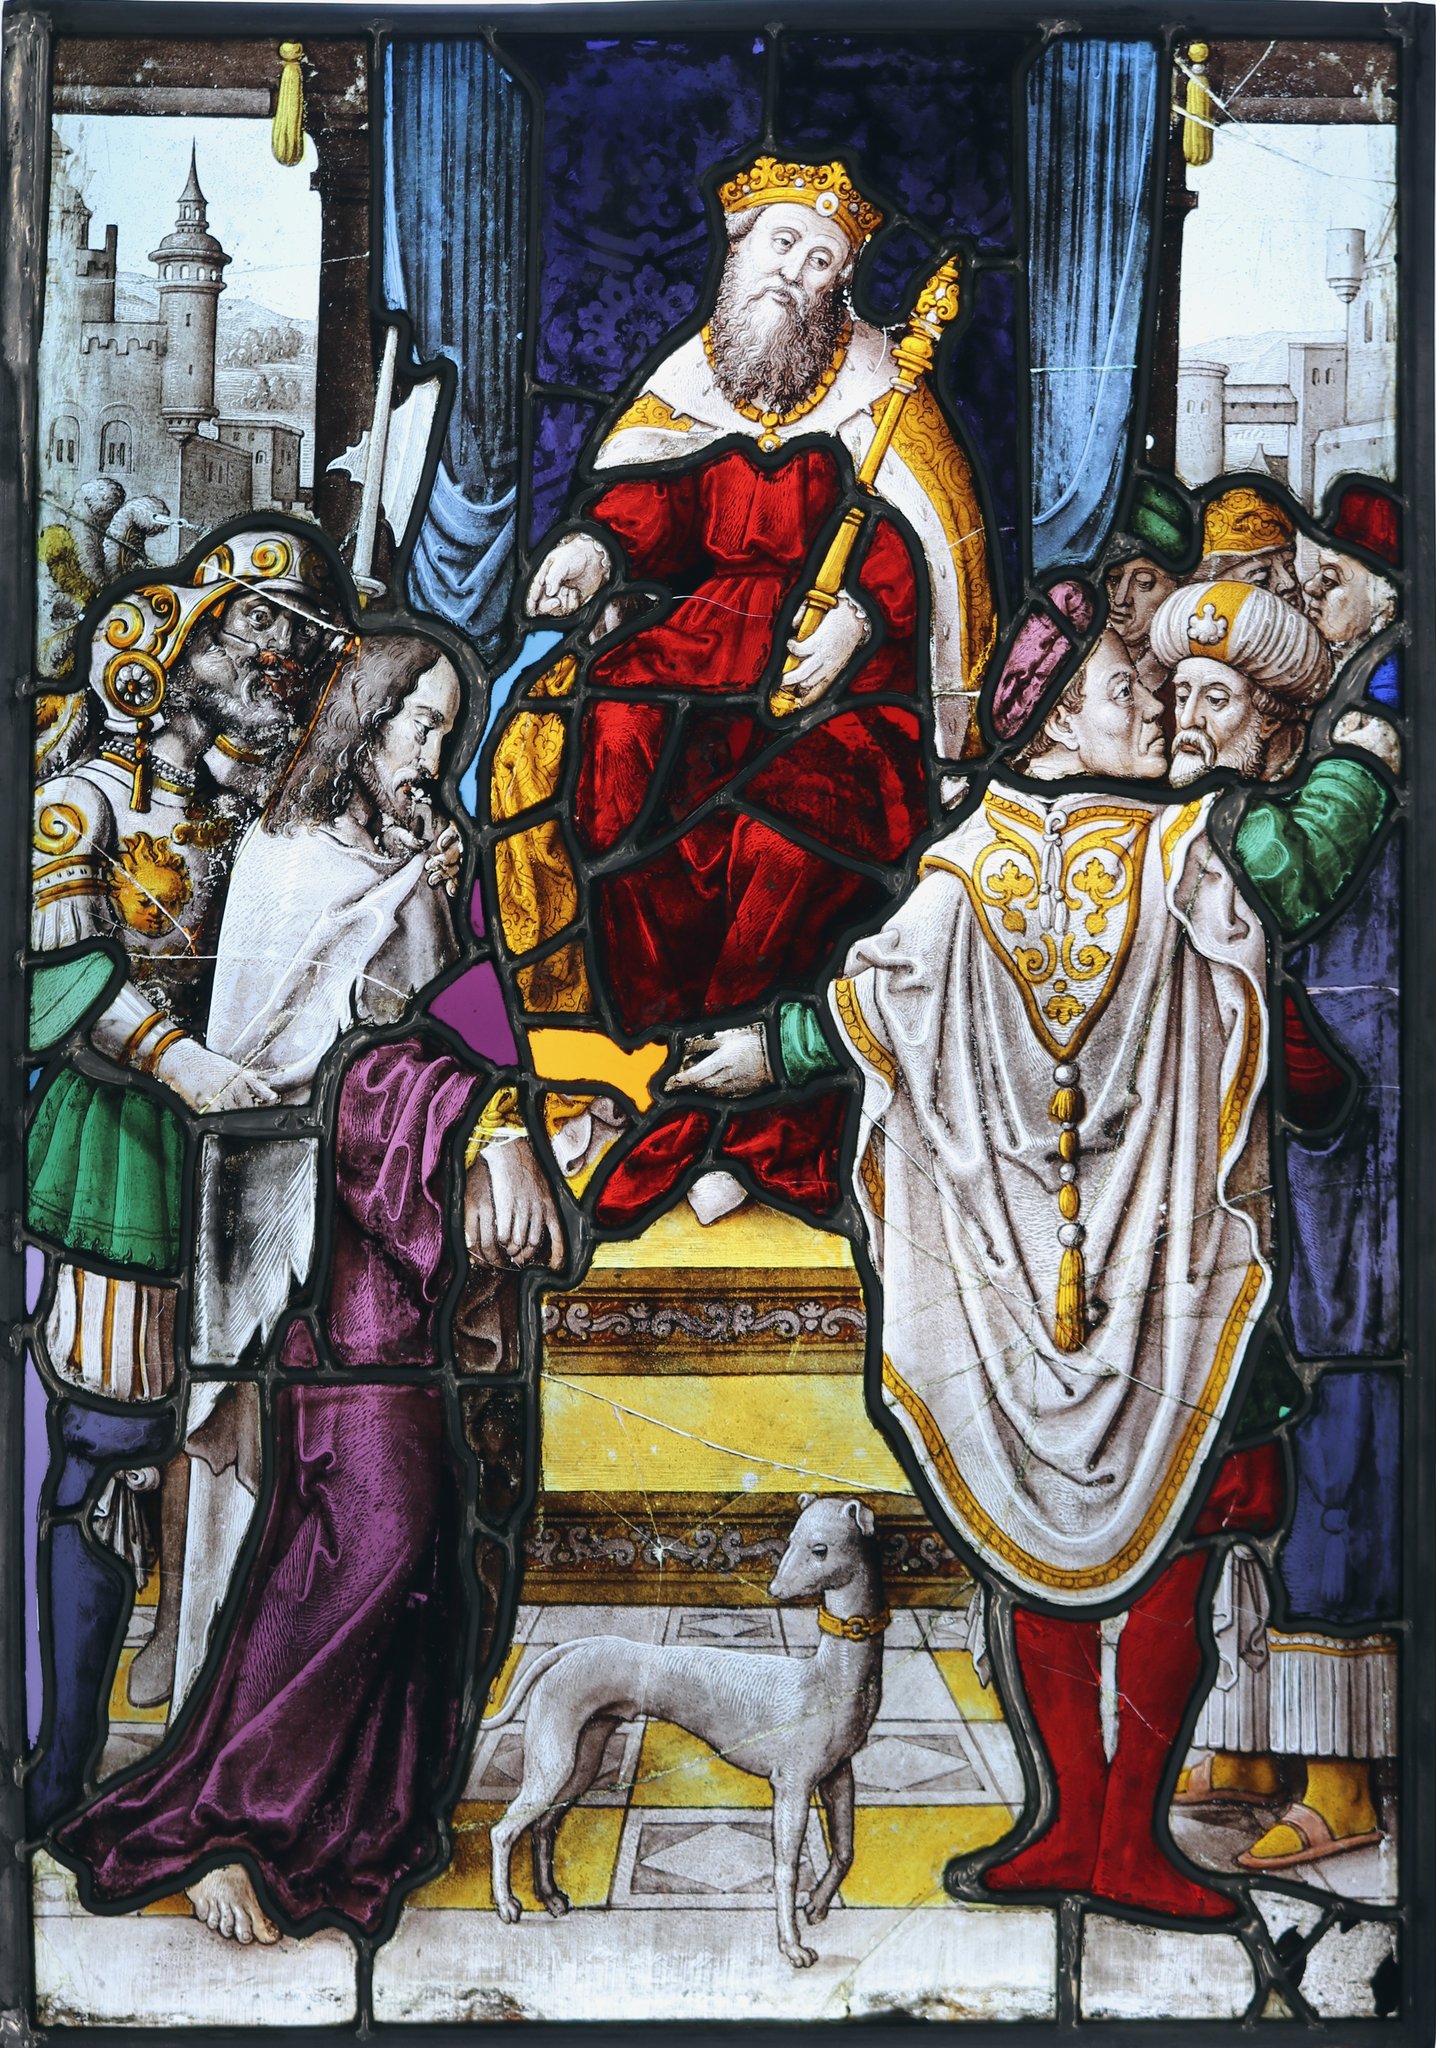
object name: panel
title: Christ Before Herod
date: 1520-1525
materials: glass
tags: kings,dogs,christ